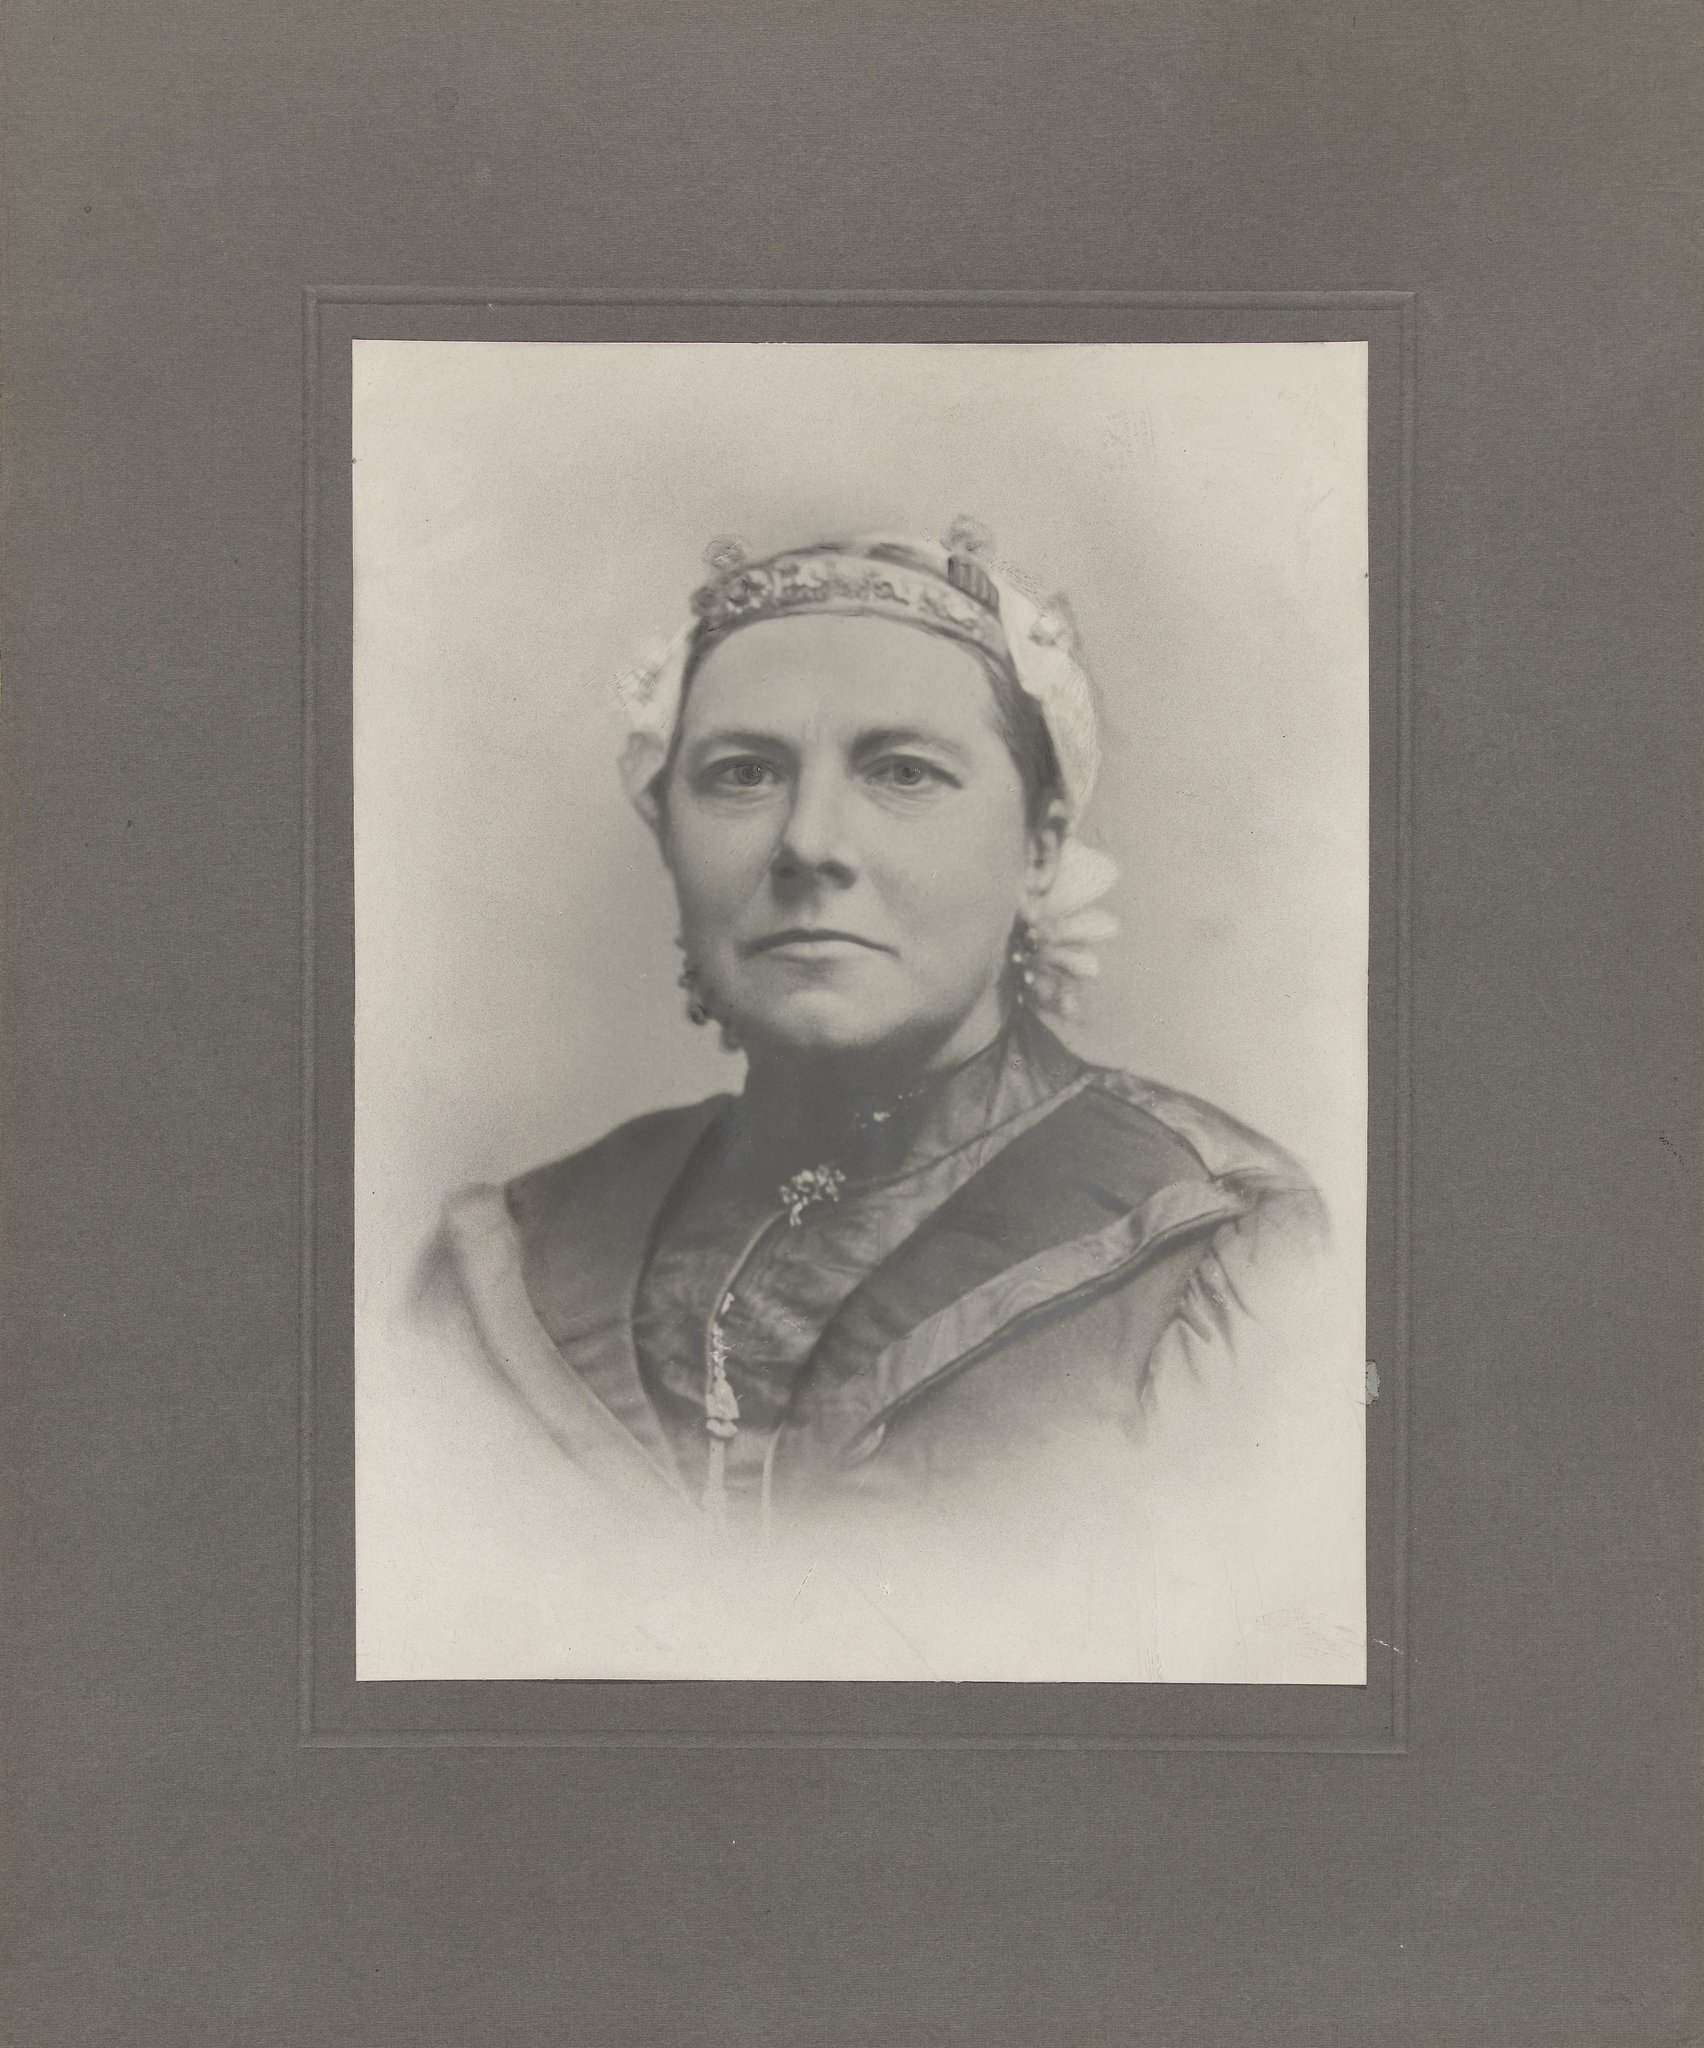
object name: photograph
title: Portret vrouw met klederdrachtkapje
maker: Anonymous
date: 1900-1920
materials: photographic support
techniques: photography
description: de foto is retoucheerd en mogelijk een vergroting